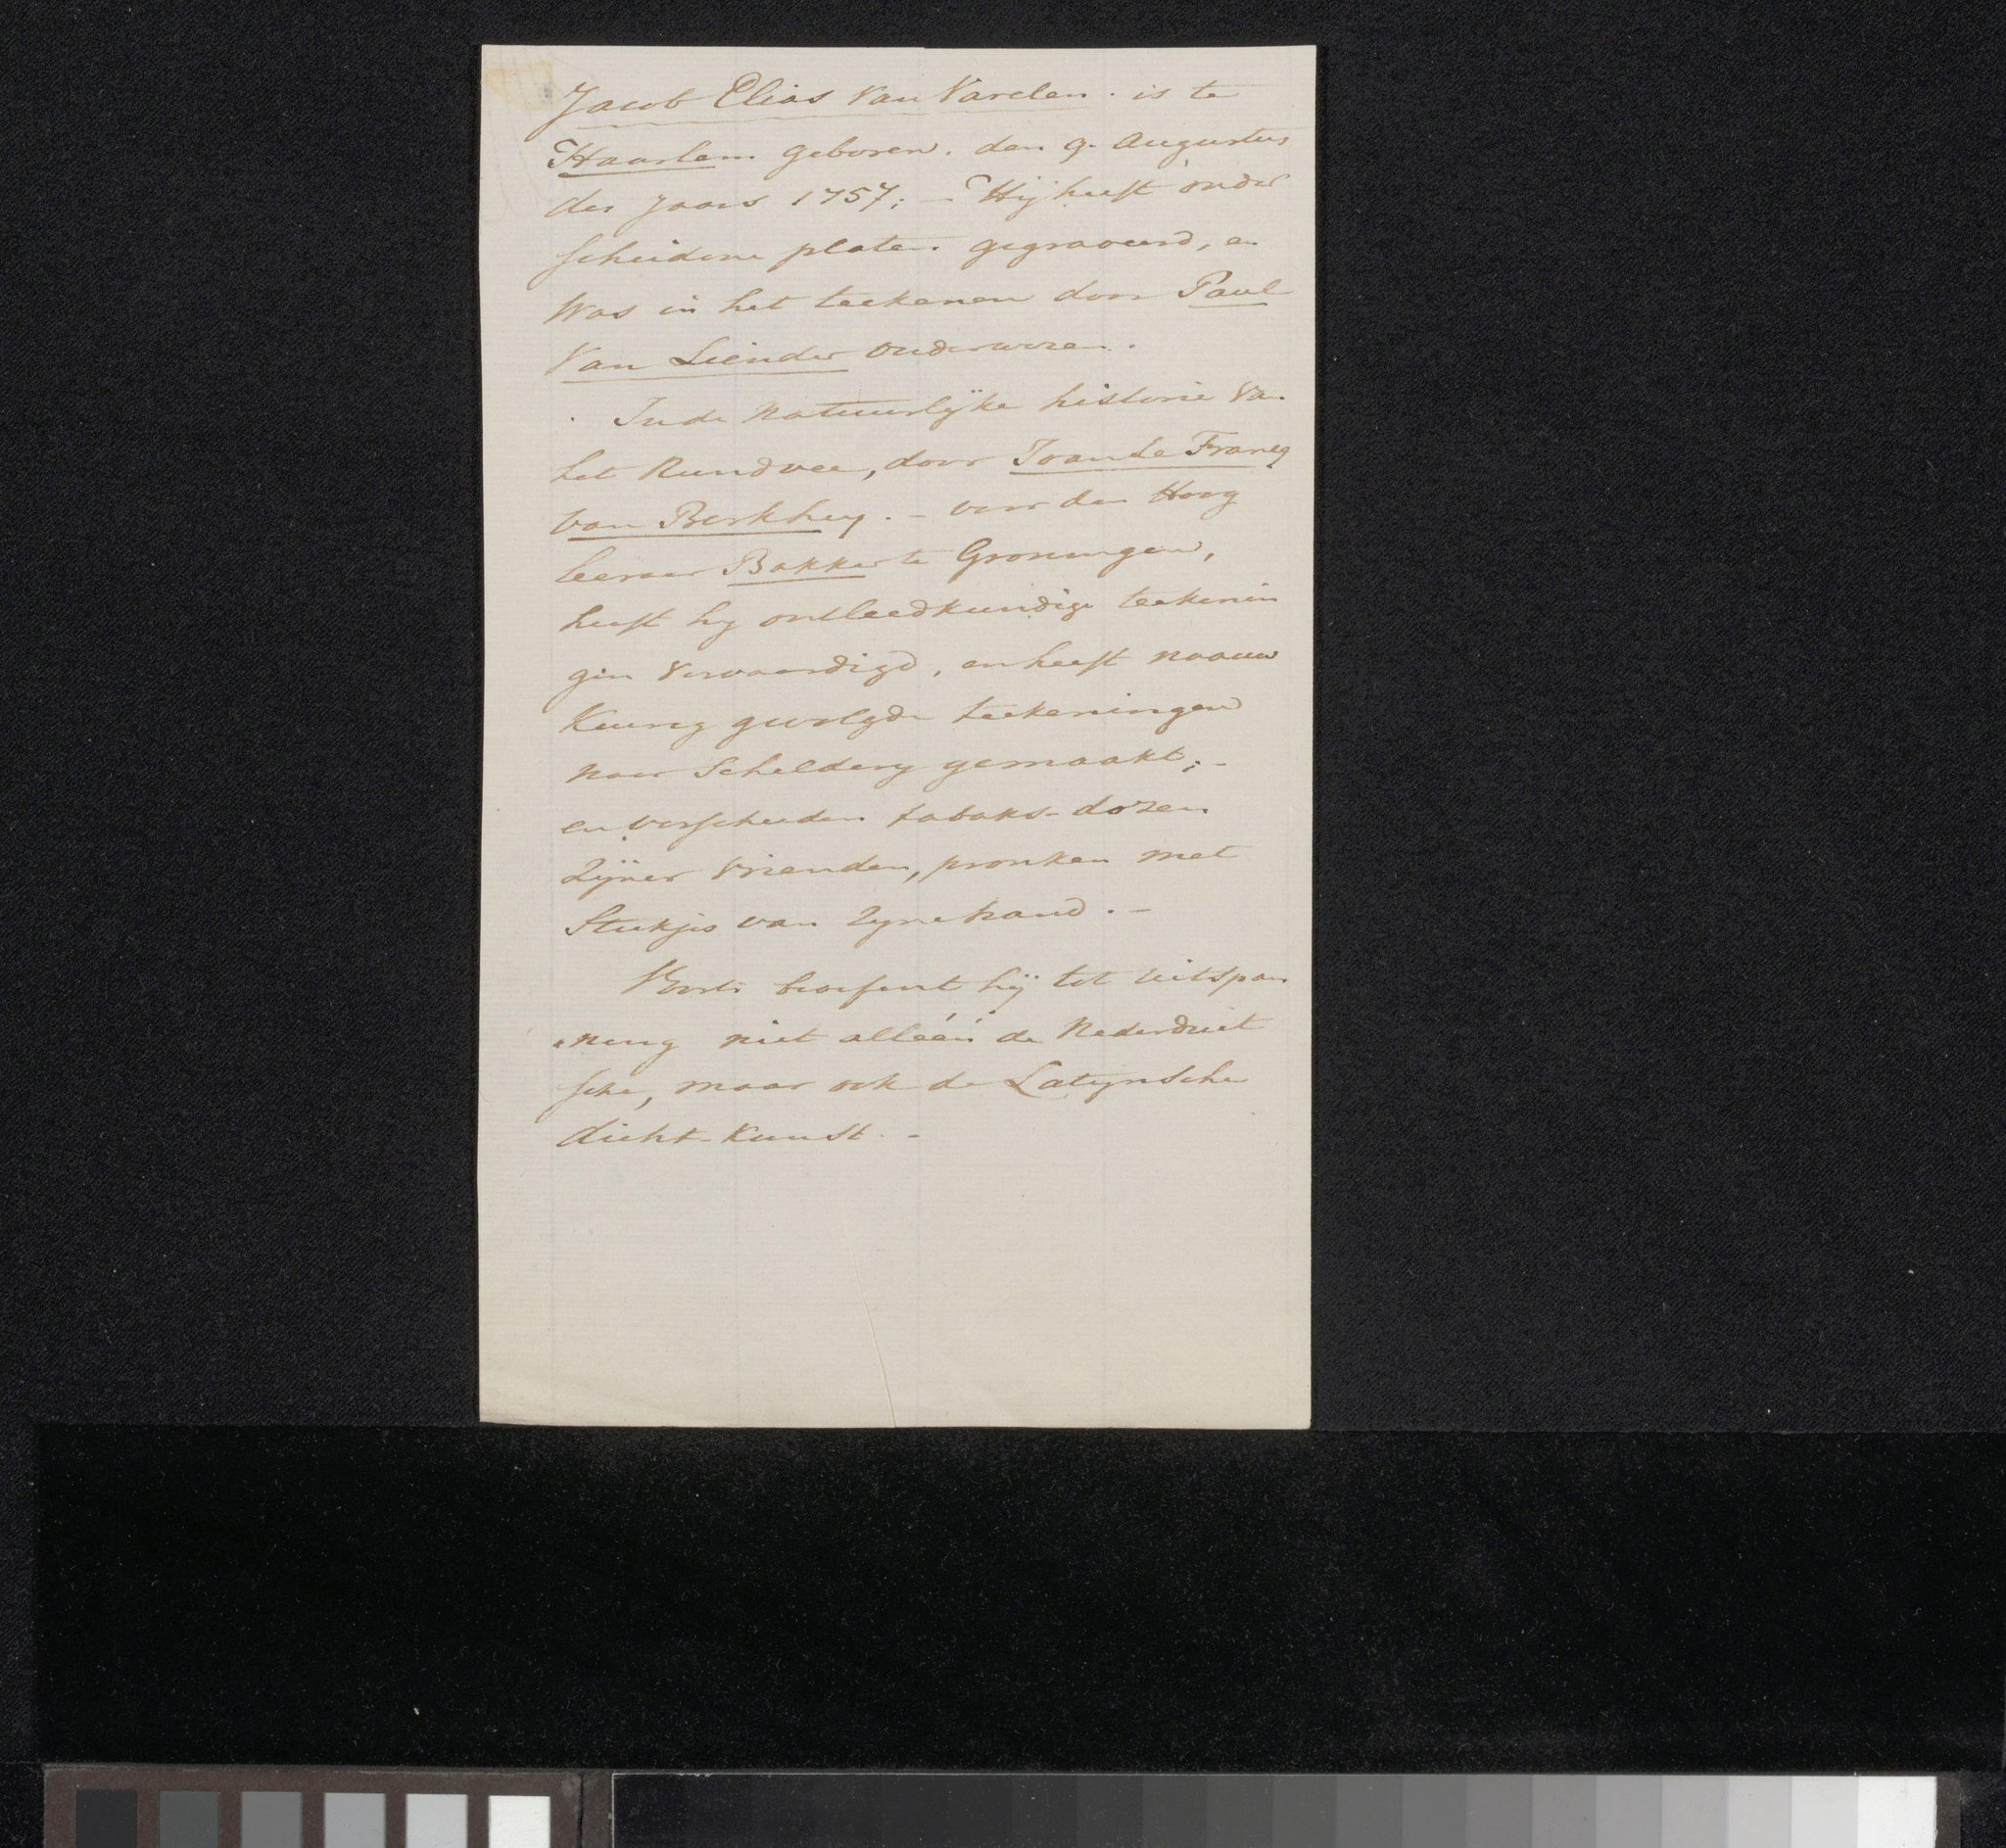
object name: letter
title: Brief aan Contze & Overbroek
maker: jacob elias van varelen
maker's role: draughtsman, print maker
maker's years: 1757-1840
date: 1828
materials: ink, paper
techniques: pen, writing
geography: haarlem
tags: contze & overbroek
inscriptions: watermark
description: Brief bevat een aantekening betreffende Jacob Elias van Varelen.